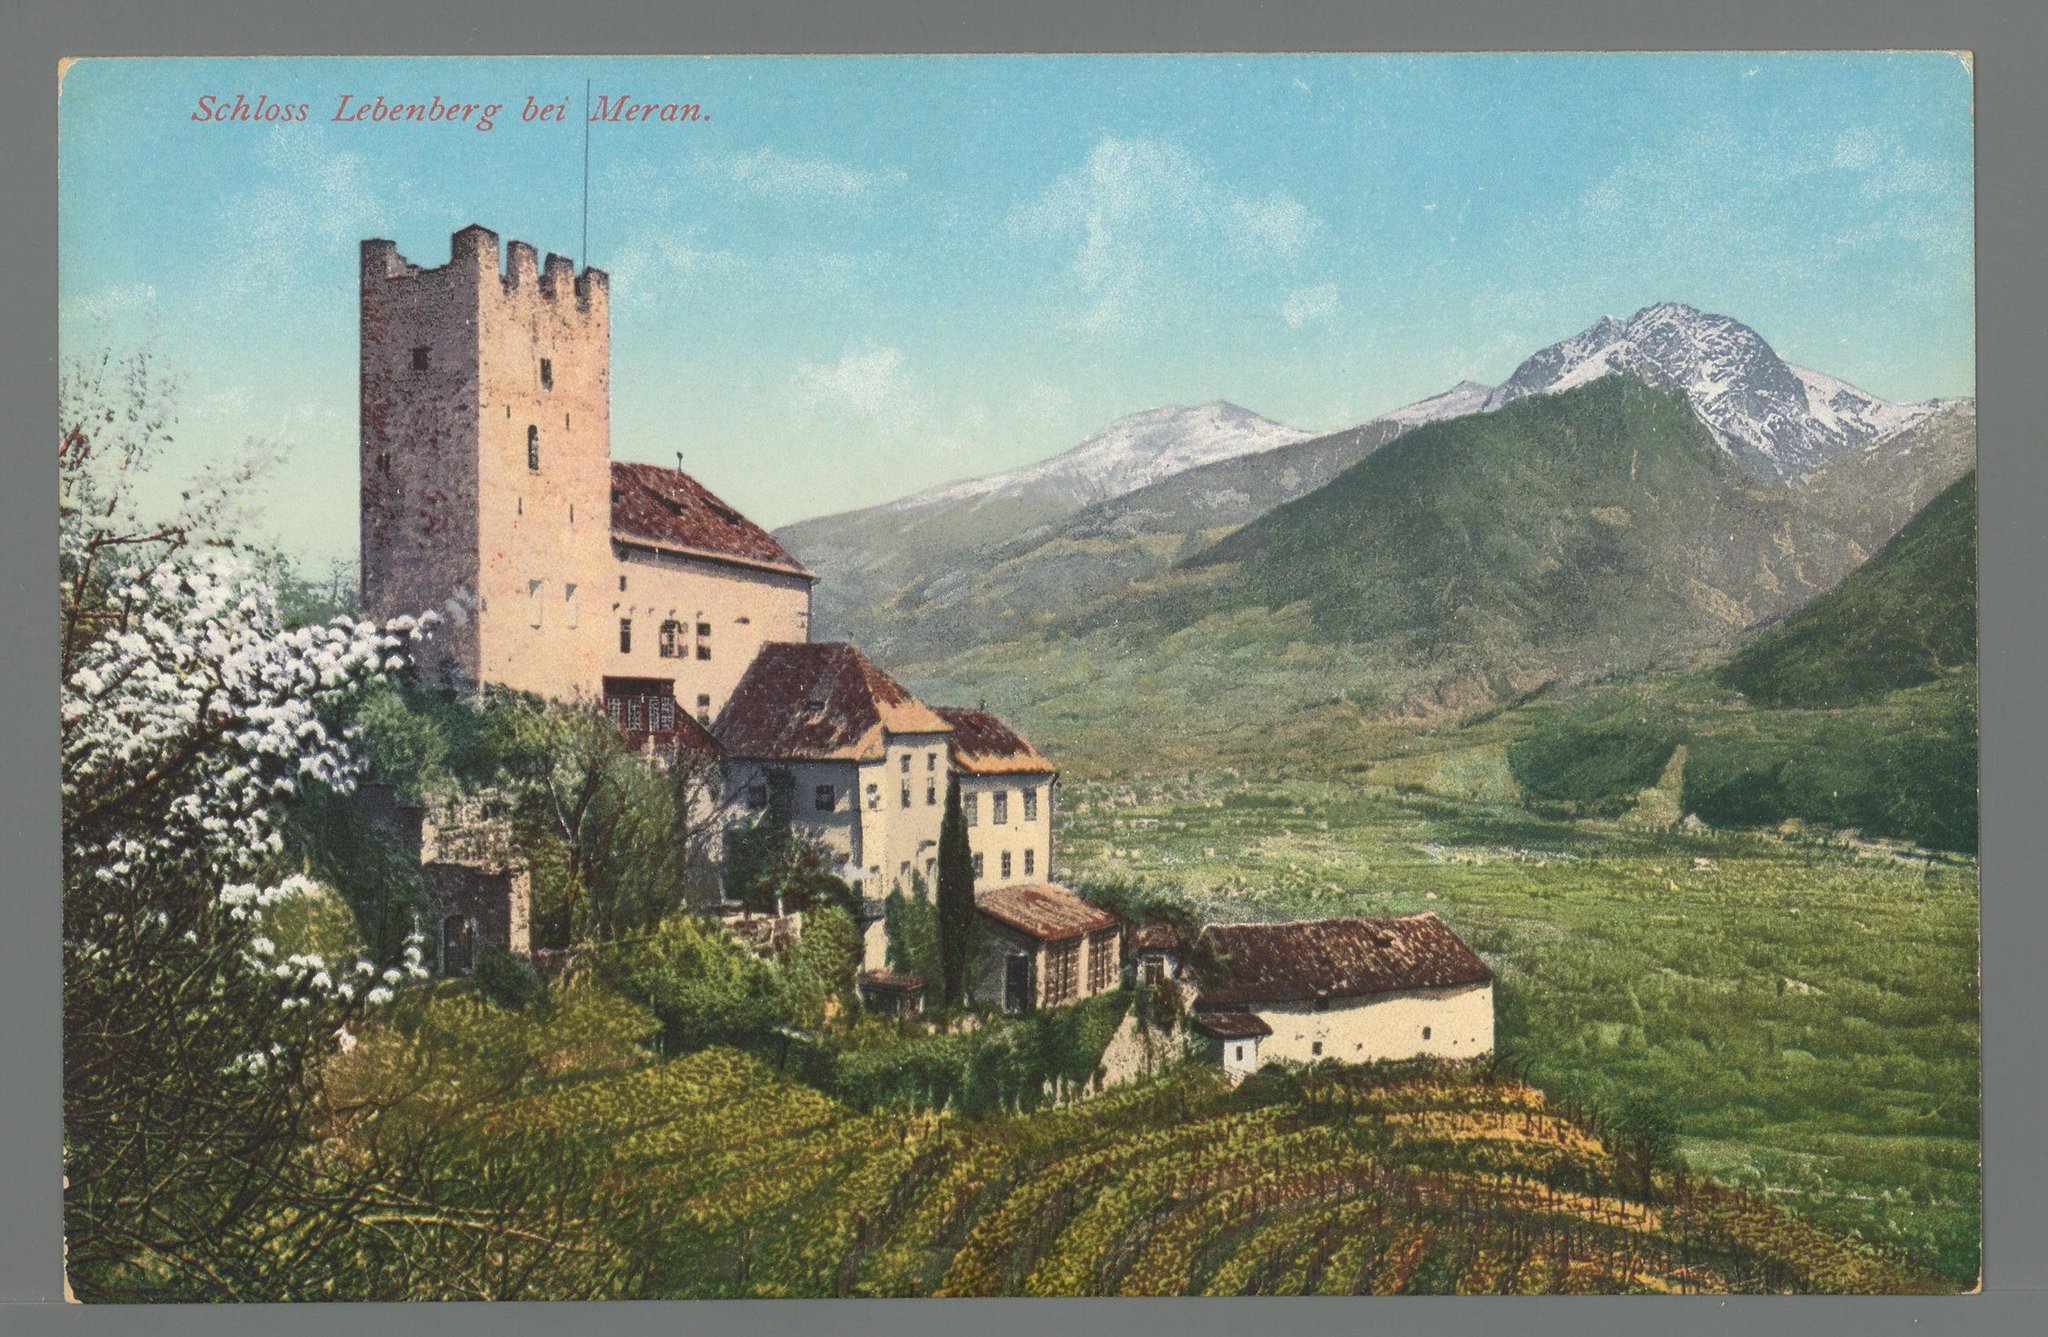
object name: ansichtkaart, prentbriefkaart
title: Schloss Lebenberg bei Meran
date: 1906-1930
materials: cardboard, photographic process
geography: merano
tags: landscape with tower or castle, mountains